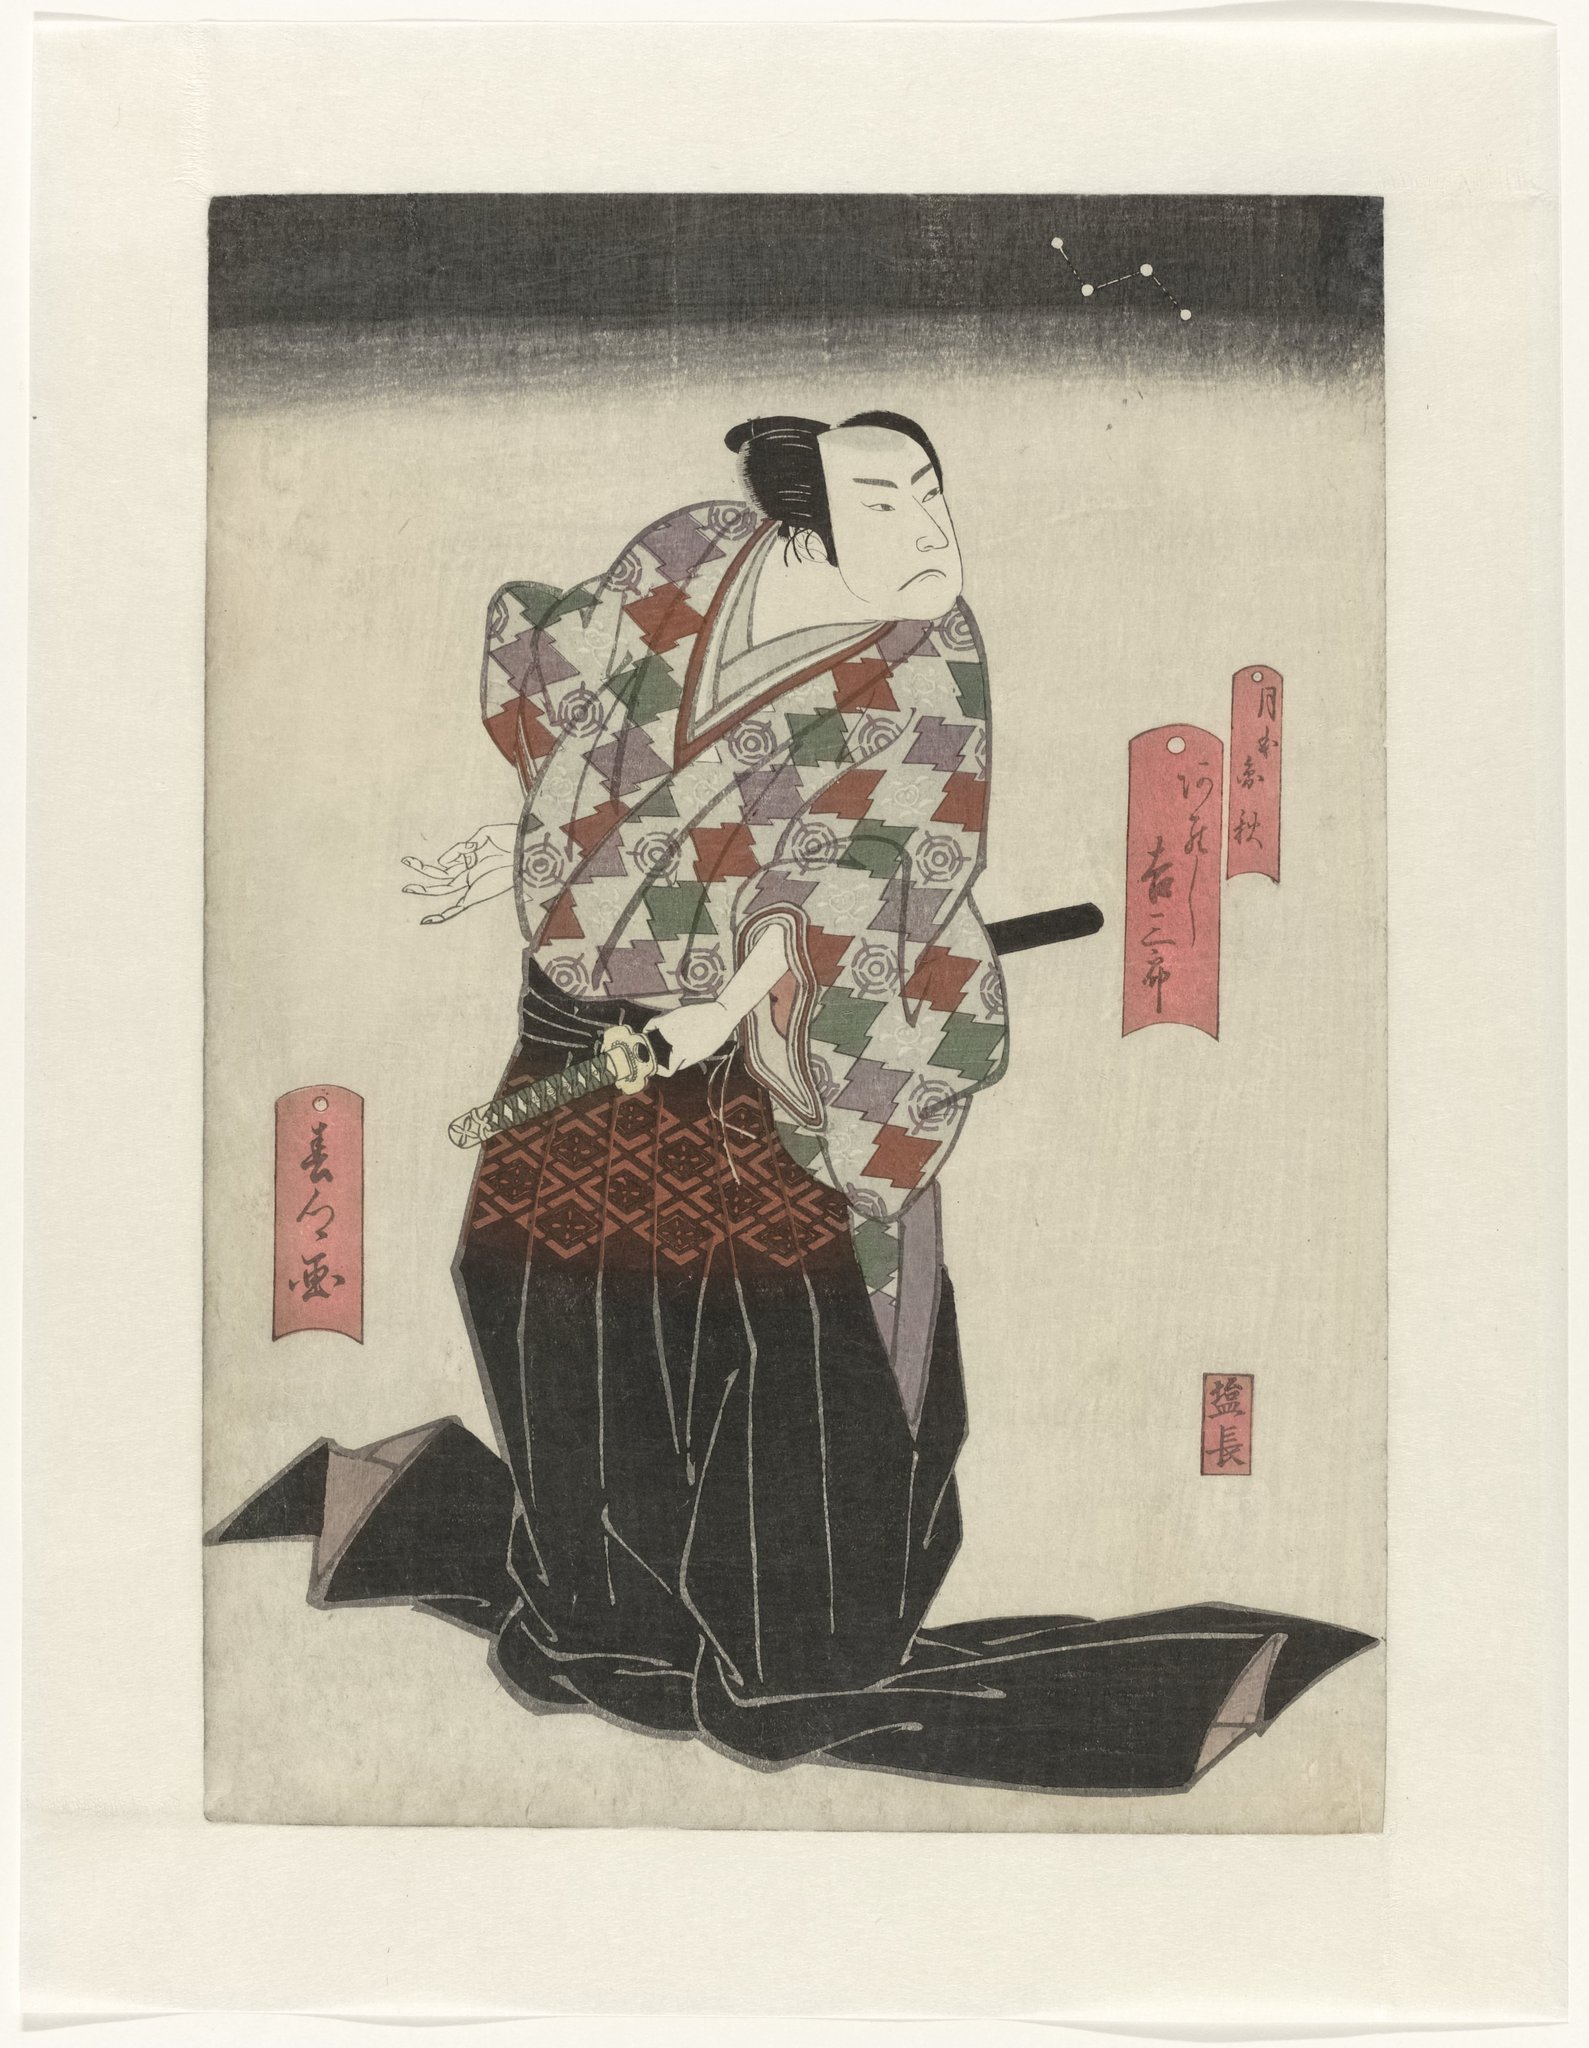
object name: print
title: Arashi Kichisaburô II als Tsukimoto Enshû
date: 1801-1815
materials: paper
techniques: woodcut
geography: osaka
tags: portrait of actor, actress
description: Arashi Kichisaburô II als Tsukimoto Enshû in het toneelstuk ‘Akiba gongen kaisen banashi’, januari 1815, Naka Theater.